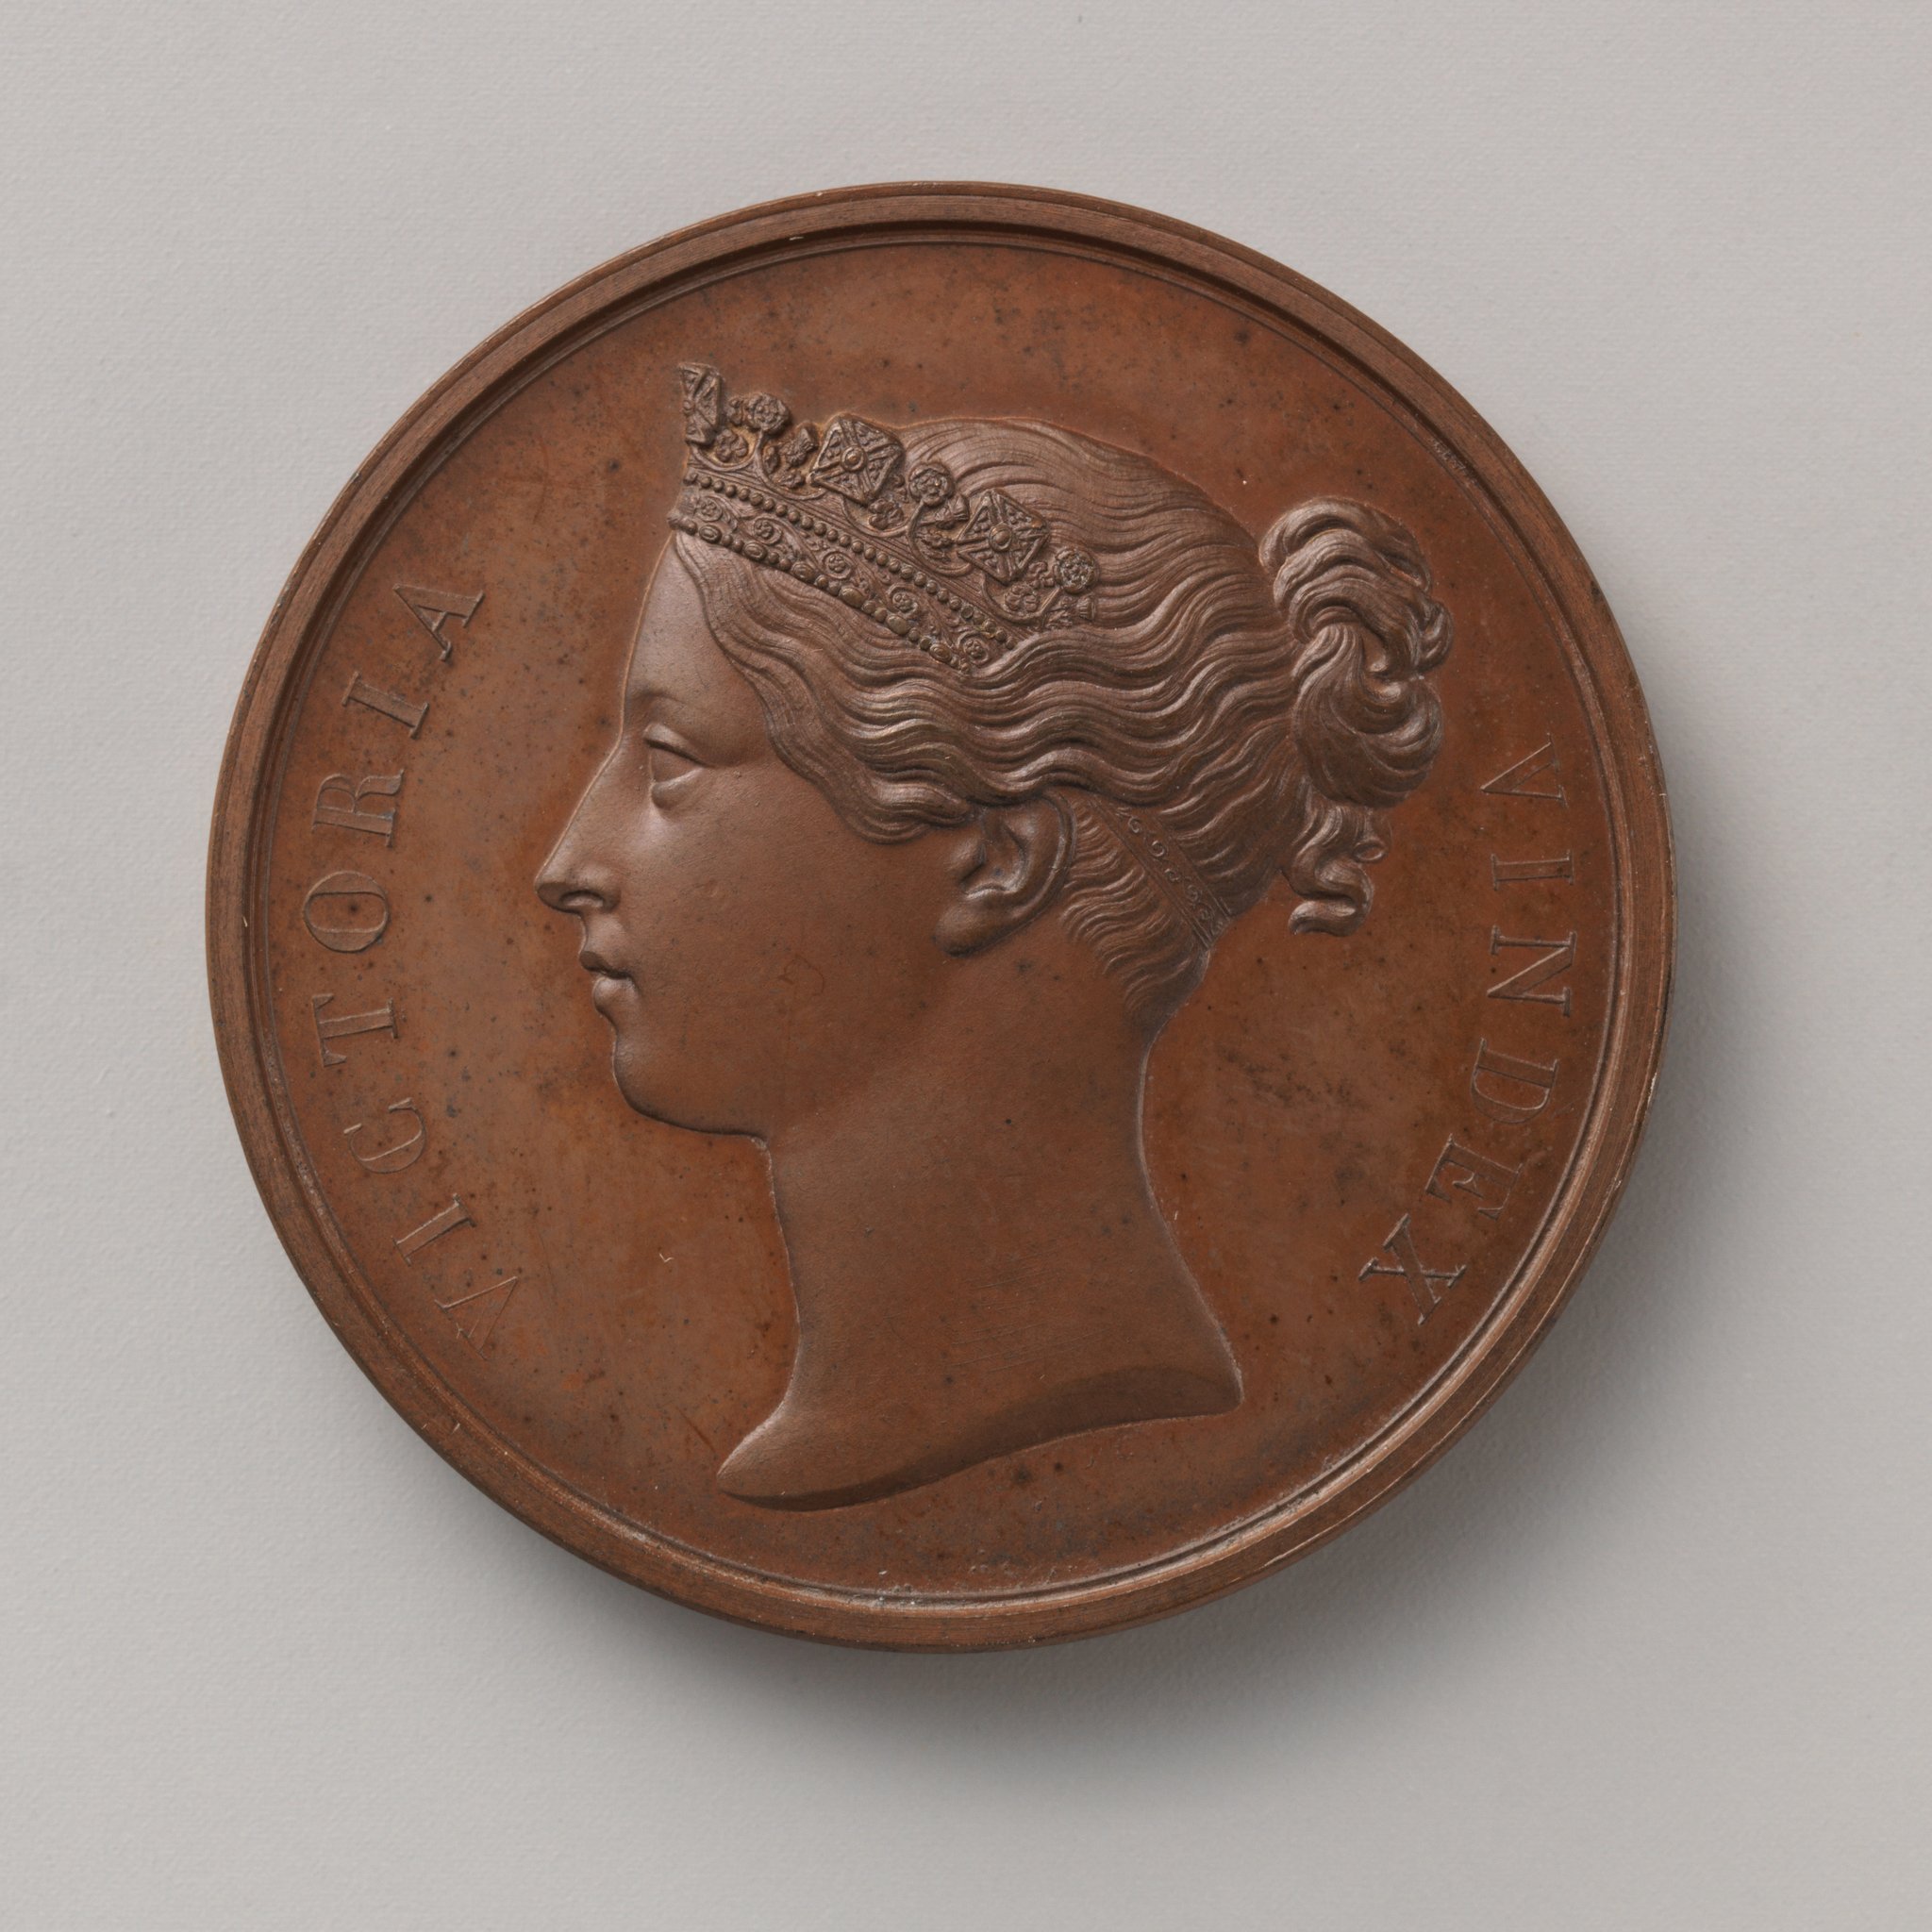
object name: medal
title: The Jellalabad Medal (Afghanistan), 1842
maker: william wyon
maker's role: artist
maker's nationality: british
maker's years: 1795-1851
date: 1842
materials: bronze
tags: profiles,women